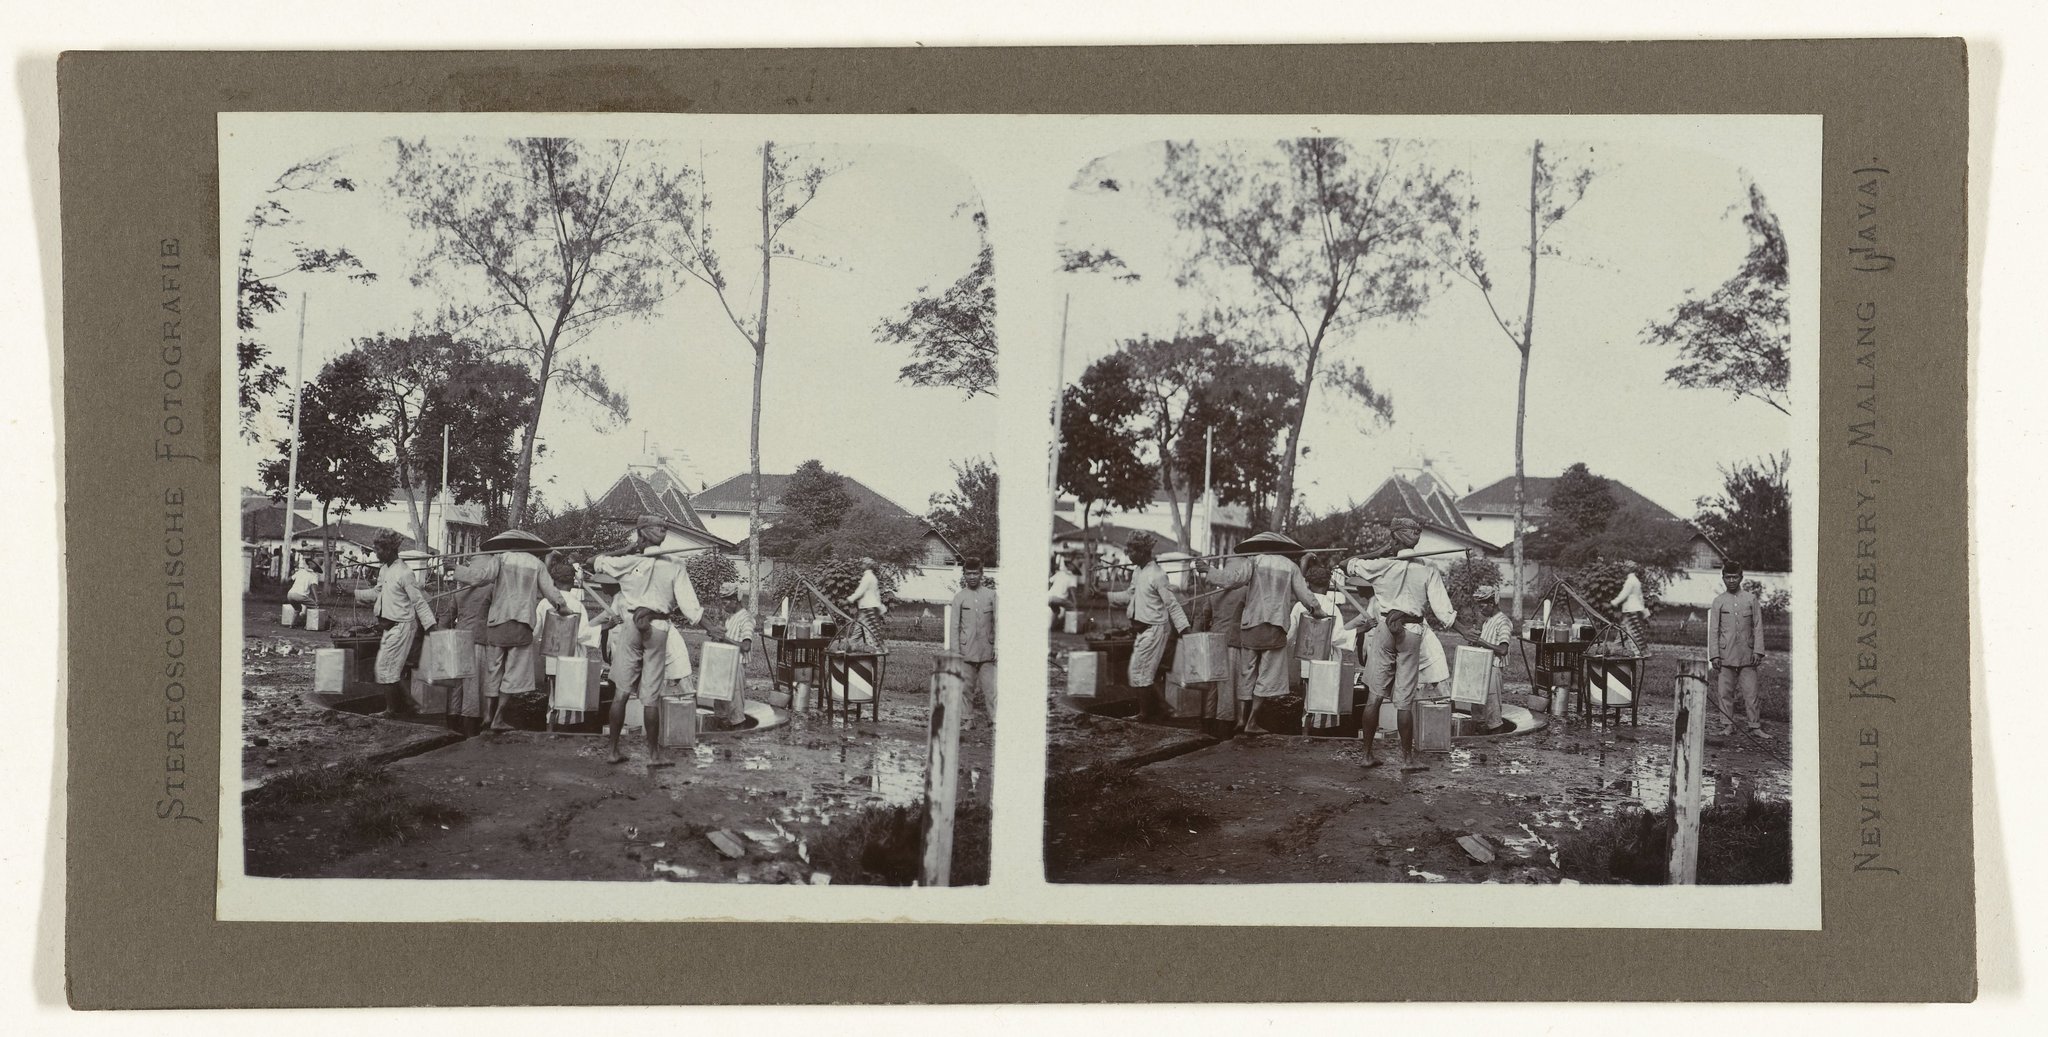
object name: photograph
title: Landbouwers bij een artesische put in Bandung.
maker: neville keasberry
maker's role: fotograaf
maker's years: 1866-1944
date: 1900-1935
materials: cardboard, paper, photographic support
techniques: albumen print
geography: malang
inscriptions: inscription: ‘Stereoscopische Fotografie’, signature: ‘Neville Keasberry, Malang (Java)’